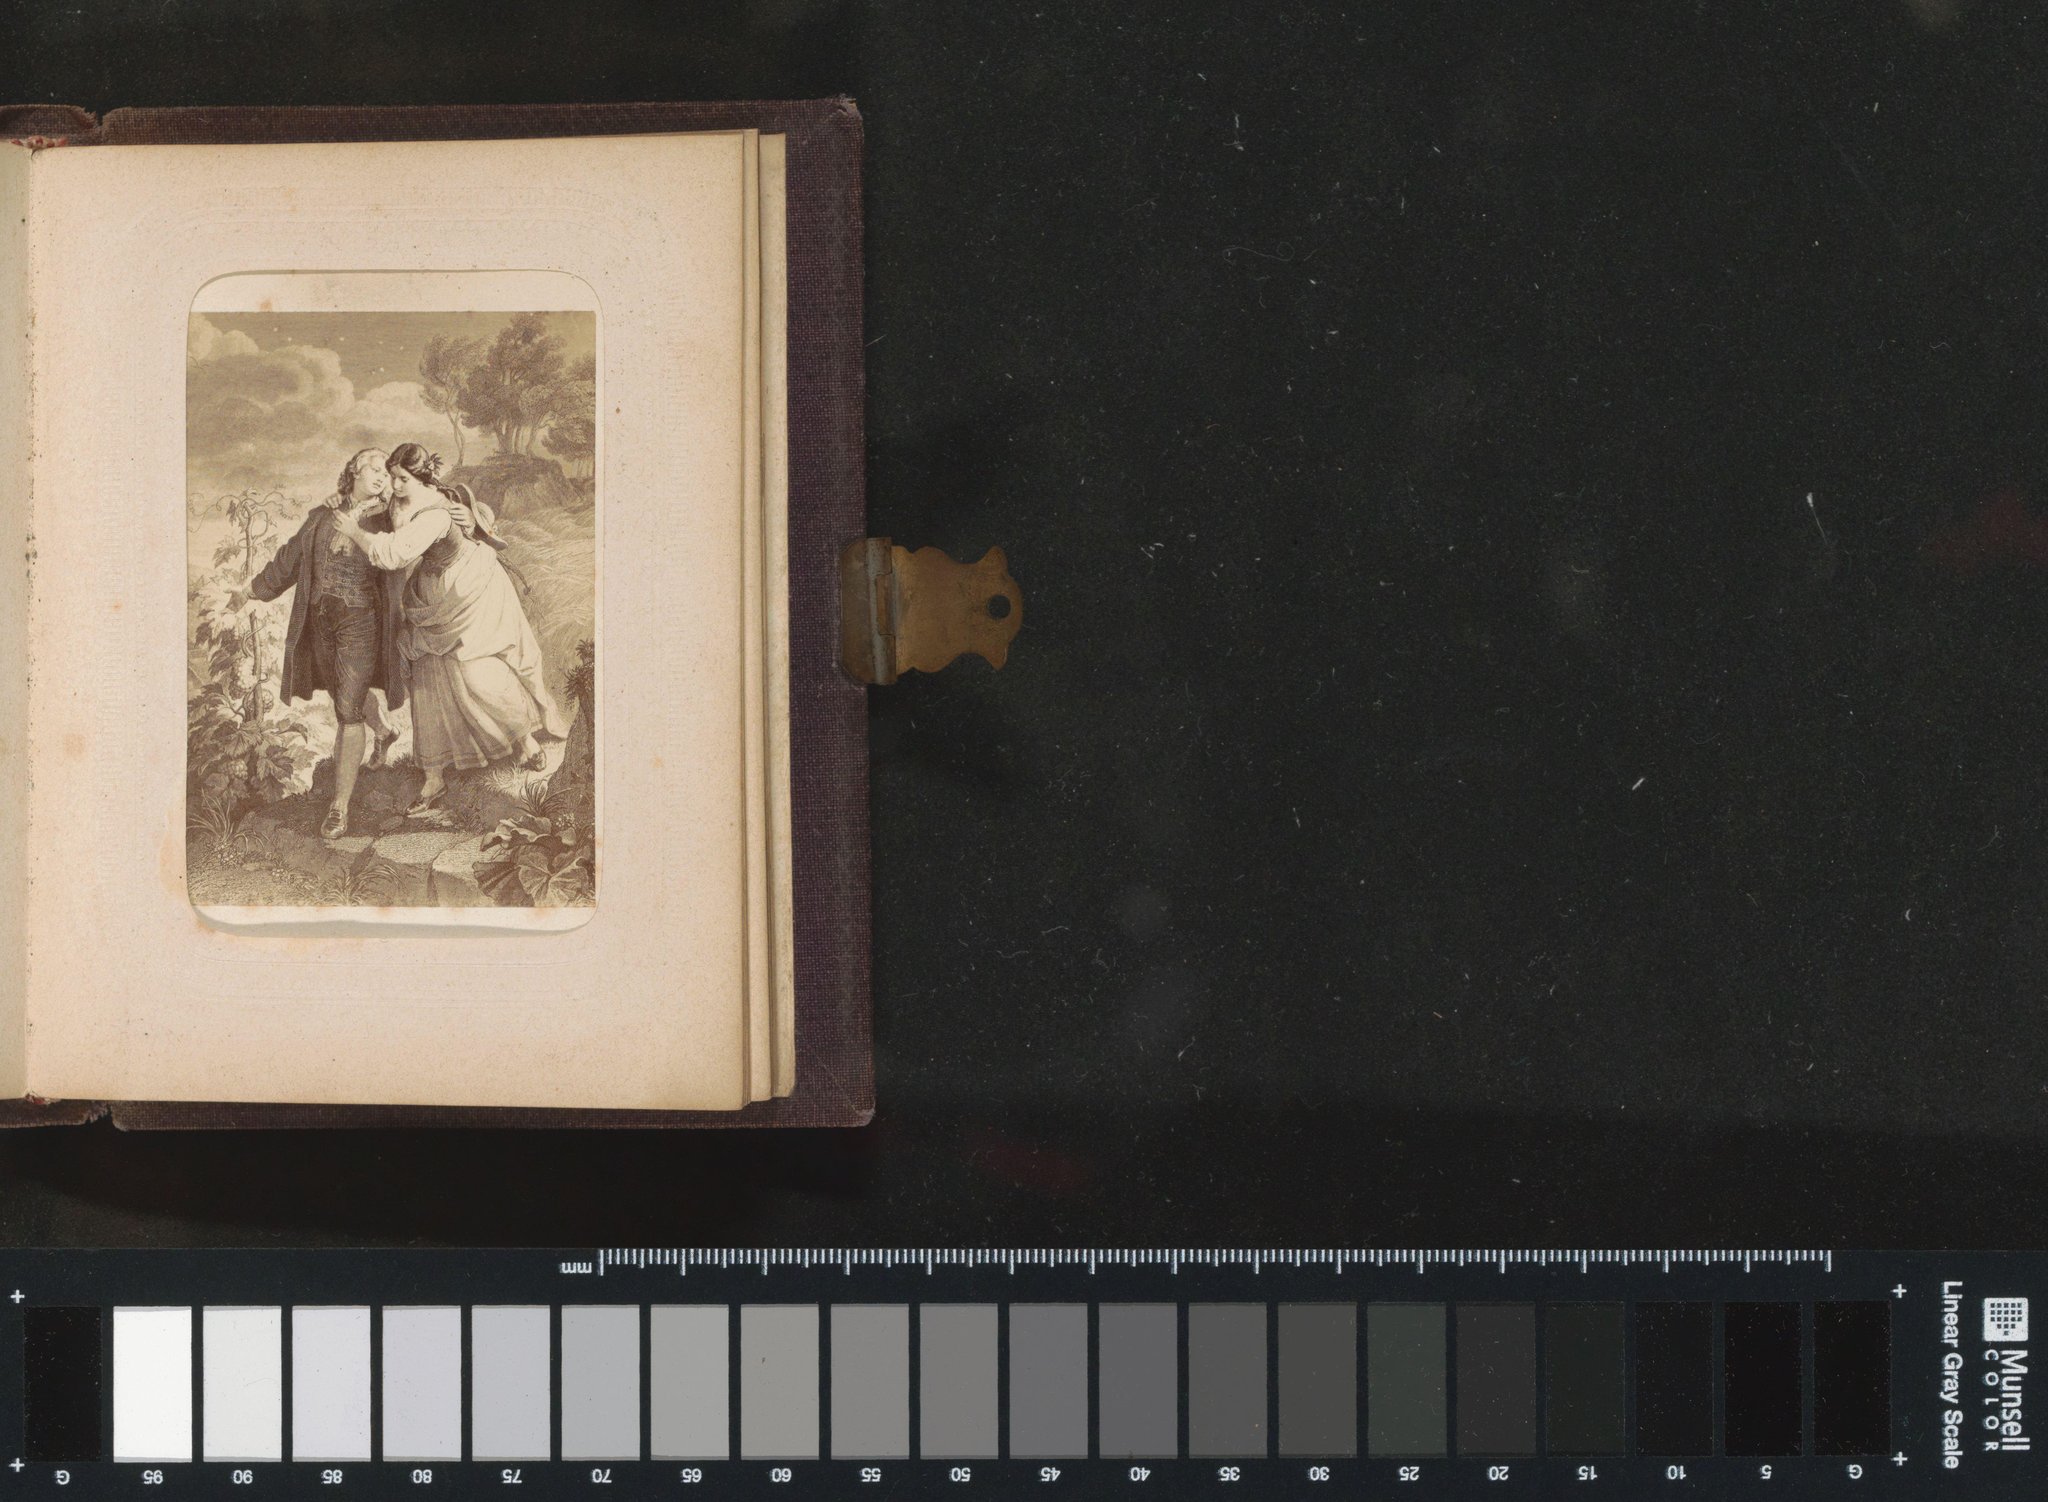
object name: reproduction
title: Fotoreproductie van (vermoedelijk) een prent naar werk van W. von Kaulbach: Dorothea (Herman und Dorothea)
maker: andries jager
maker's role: publisher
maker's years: 1825-1905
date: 1860-1890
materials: cardboard, paper, photographic support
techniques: albumen print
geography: amsterdam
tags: adolescent, young woman, maiden, couple of lovers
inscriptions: address: ‘Water 110 Amsterdam’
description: Onderdeel van Fotoalbum met 16 cartes-de-visite van vrouwenfiguren uit het werk van J.W. von Goethe.